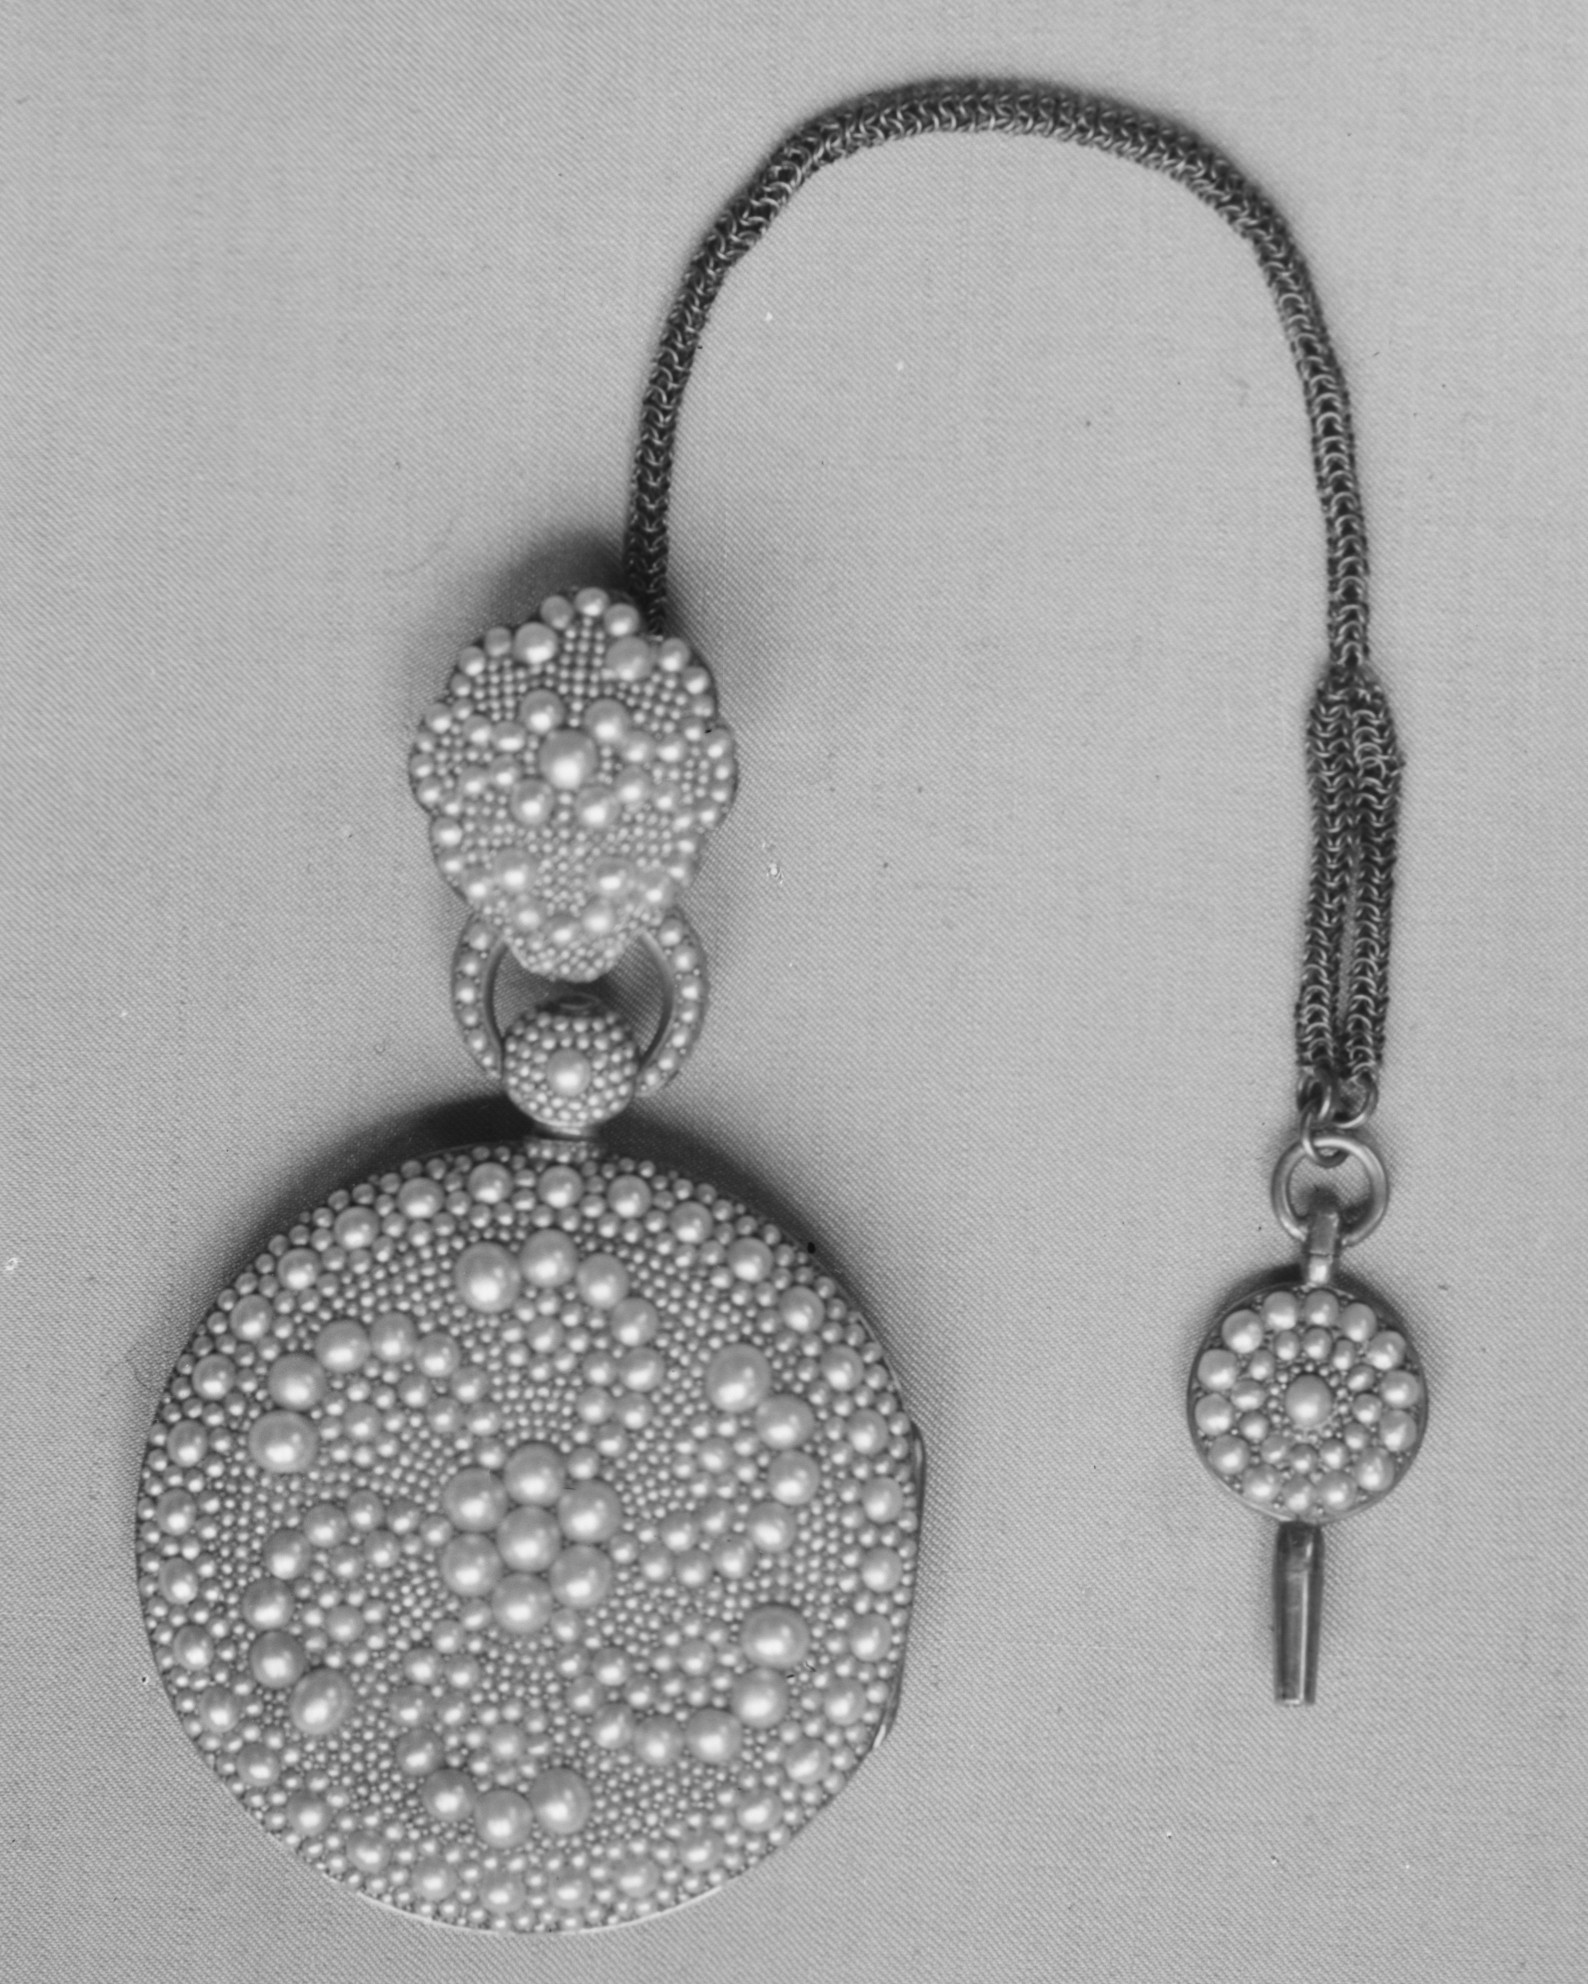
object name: watch with key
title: Watch and key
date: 1830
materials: gold, pearl